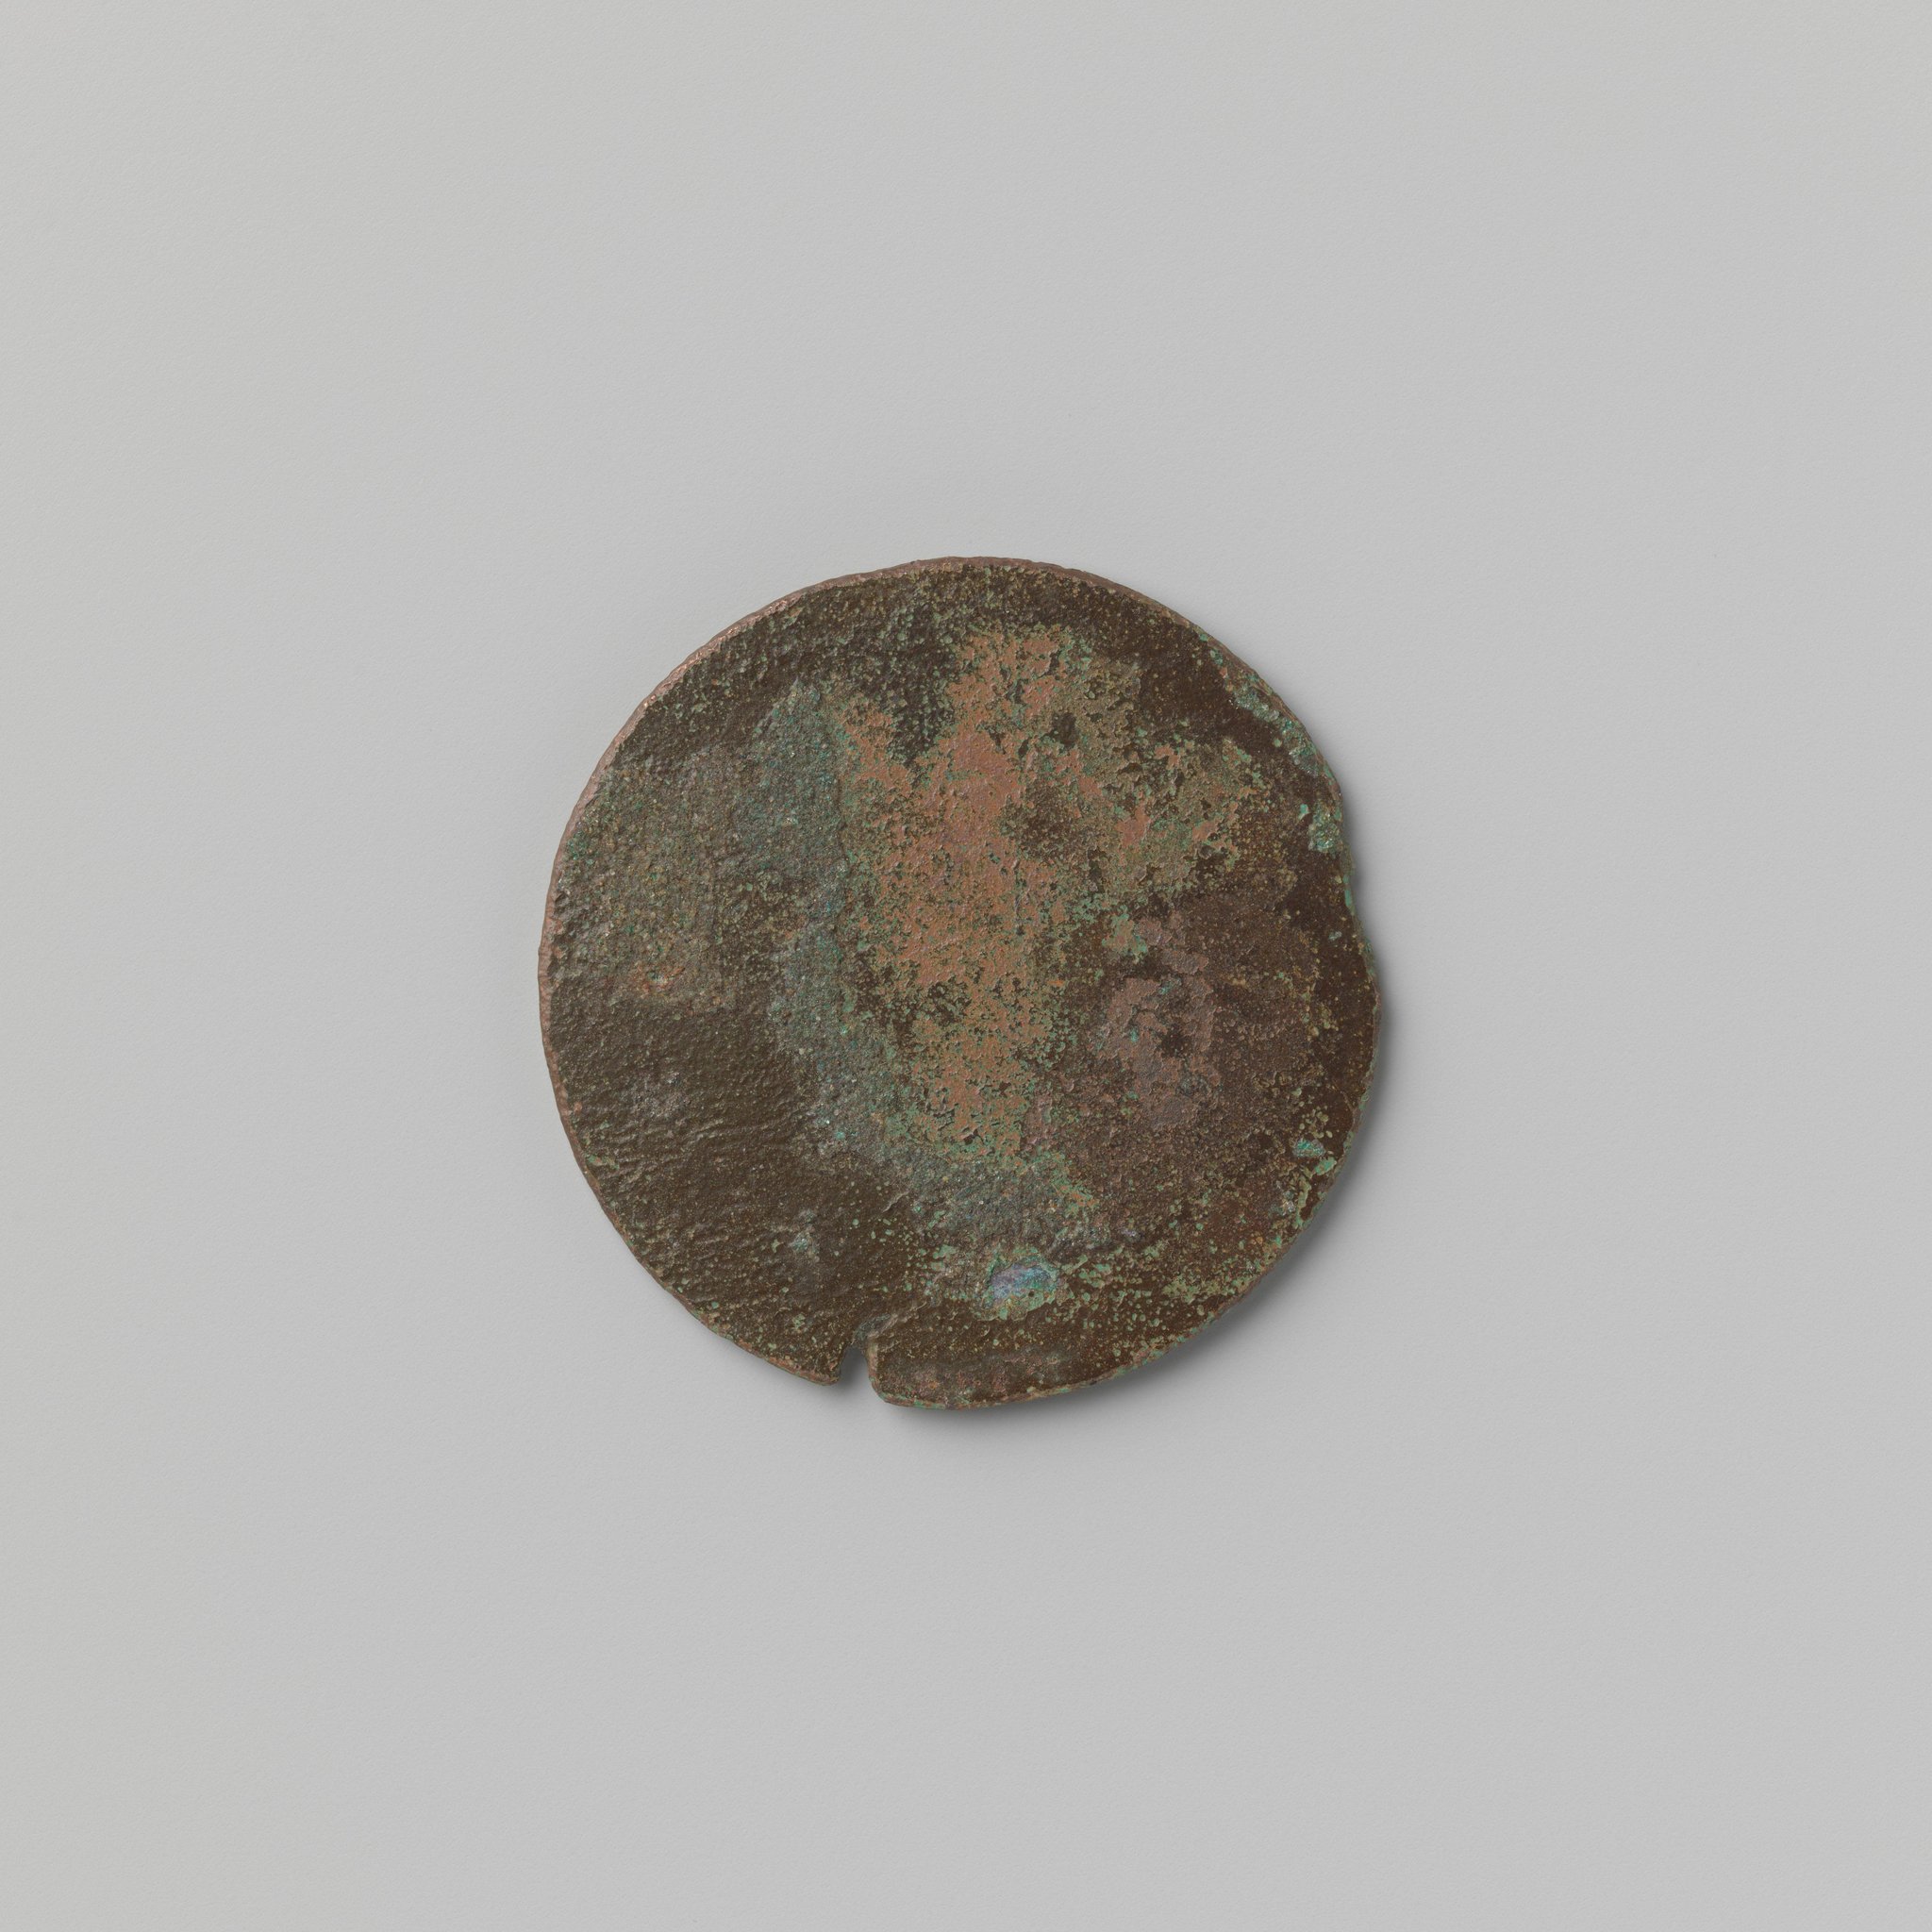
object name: rondel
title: Rondel (ongeslagen muntplaatje)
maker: Anonymous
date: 1700-1800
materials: copper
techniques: striking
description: Rondel, gevonden op het strand van Terschelling, waarschijnlijk van Zweedse oorsprong en in Göteborg of Hamburg ingeladen in een schip dat – op weg naar Lissabon – nabij Terschelling zonk.